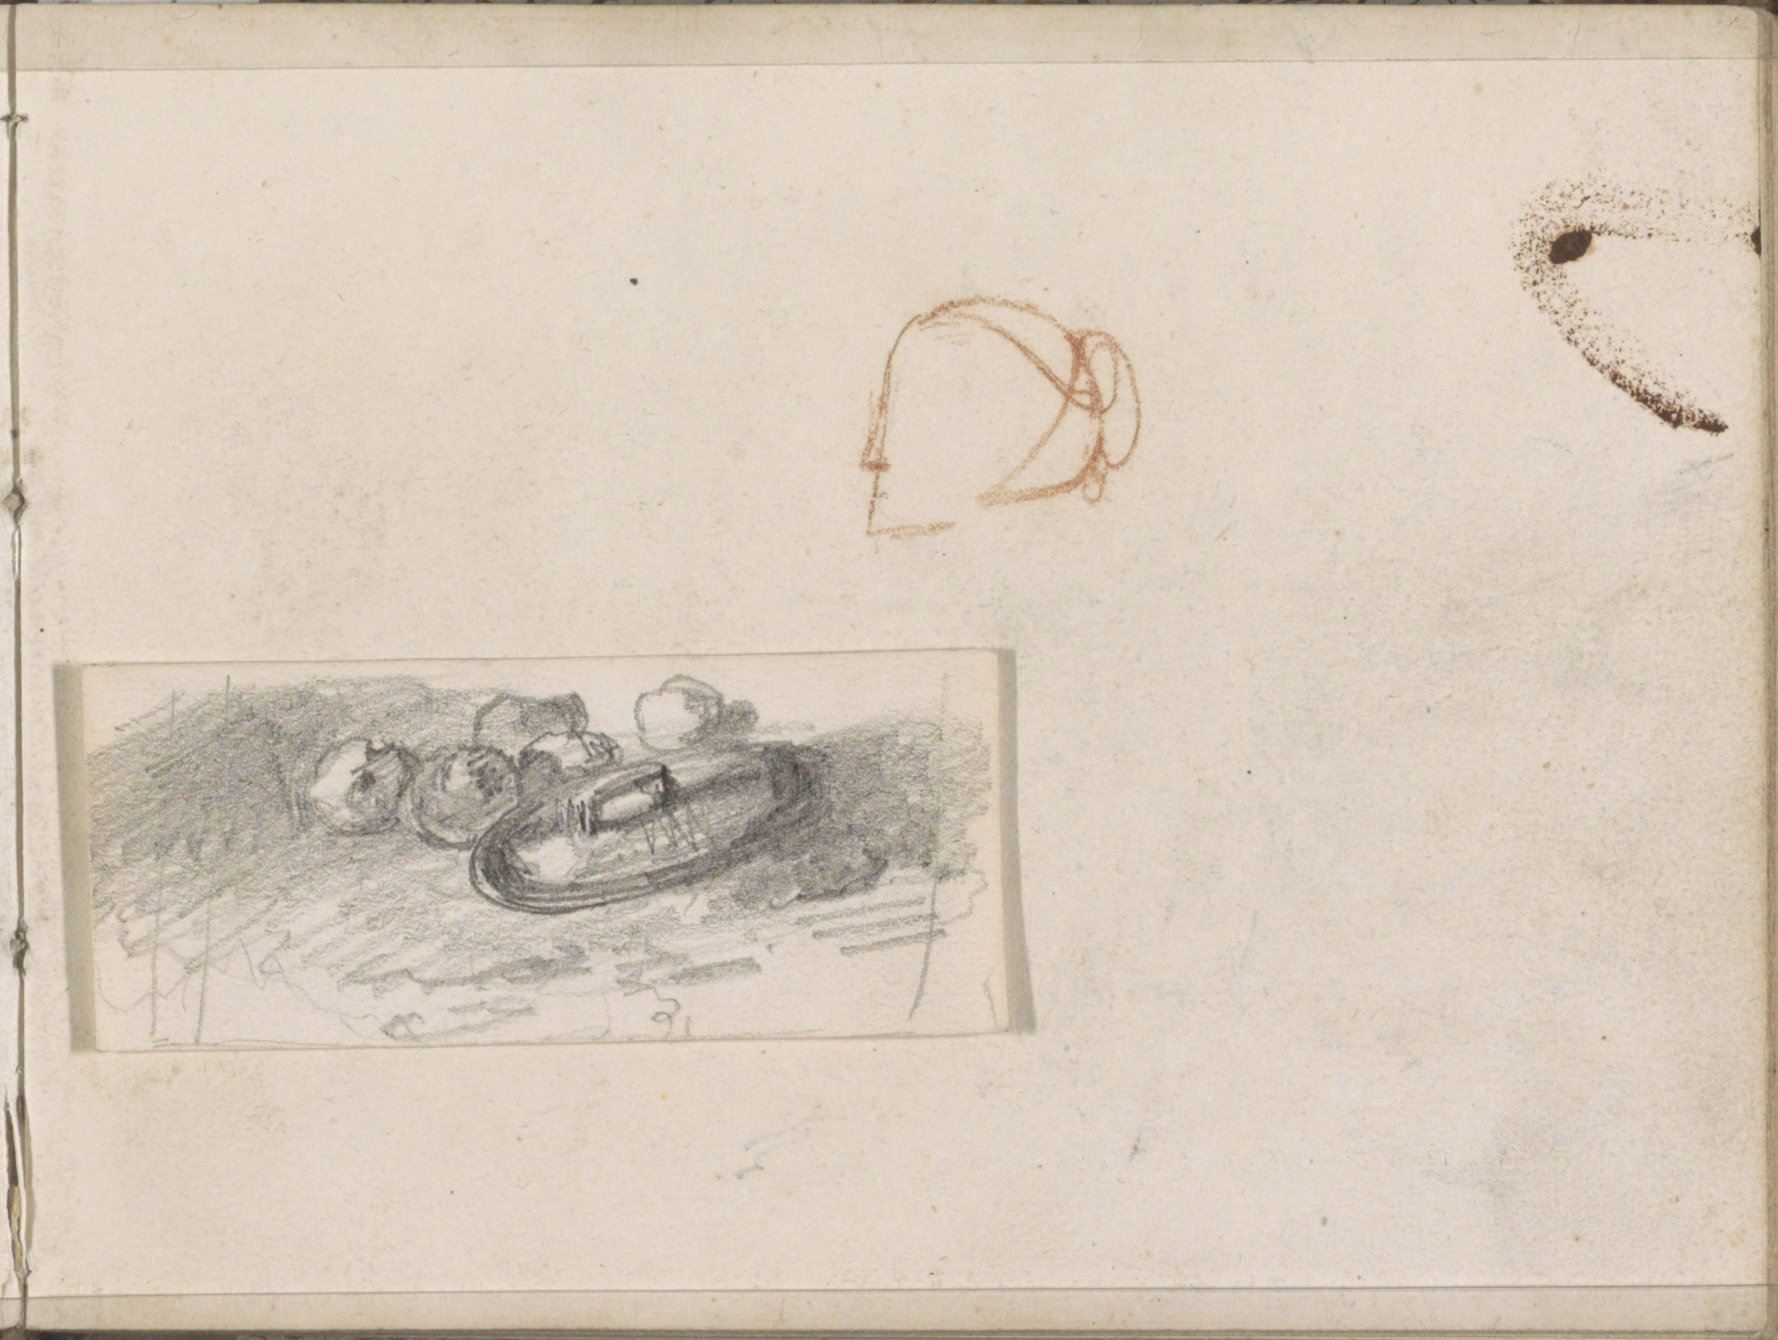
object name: sketchbook leaf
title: Stilleven met appels en een deksel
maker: maria vos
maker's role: draughtsman, painter, print maker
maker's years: 1824-1906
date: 1834-1906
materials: paper, pencil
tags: still life of miscellaneous objects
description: Los blad tussen het voorste schutblad en pagina 1 van een schetsboek met 21 bladen.